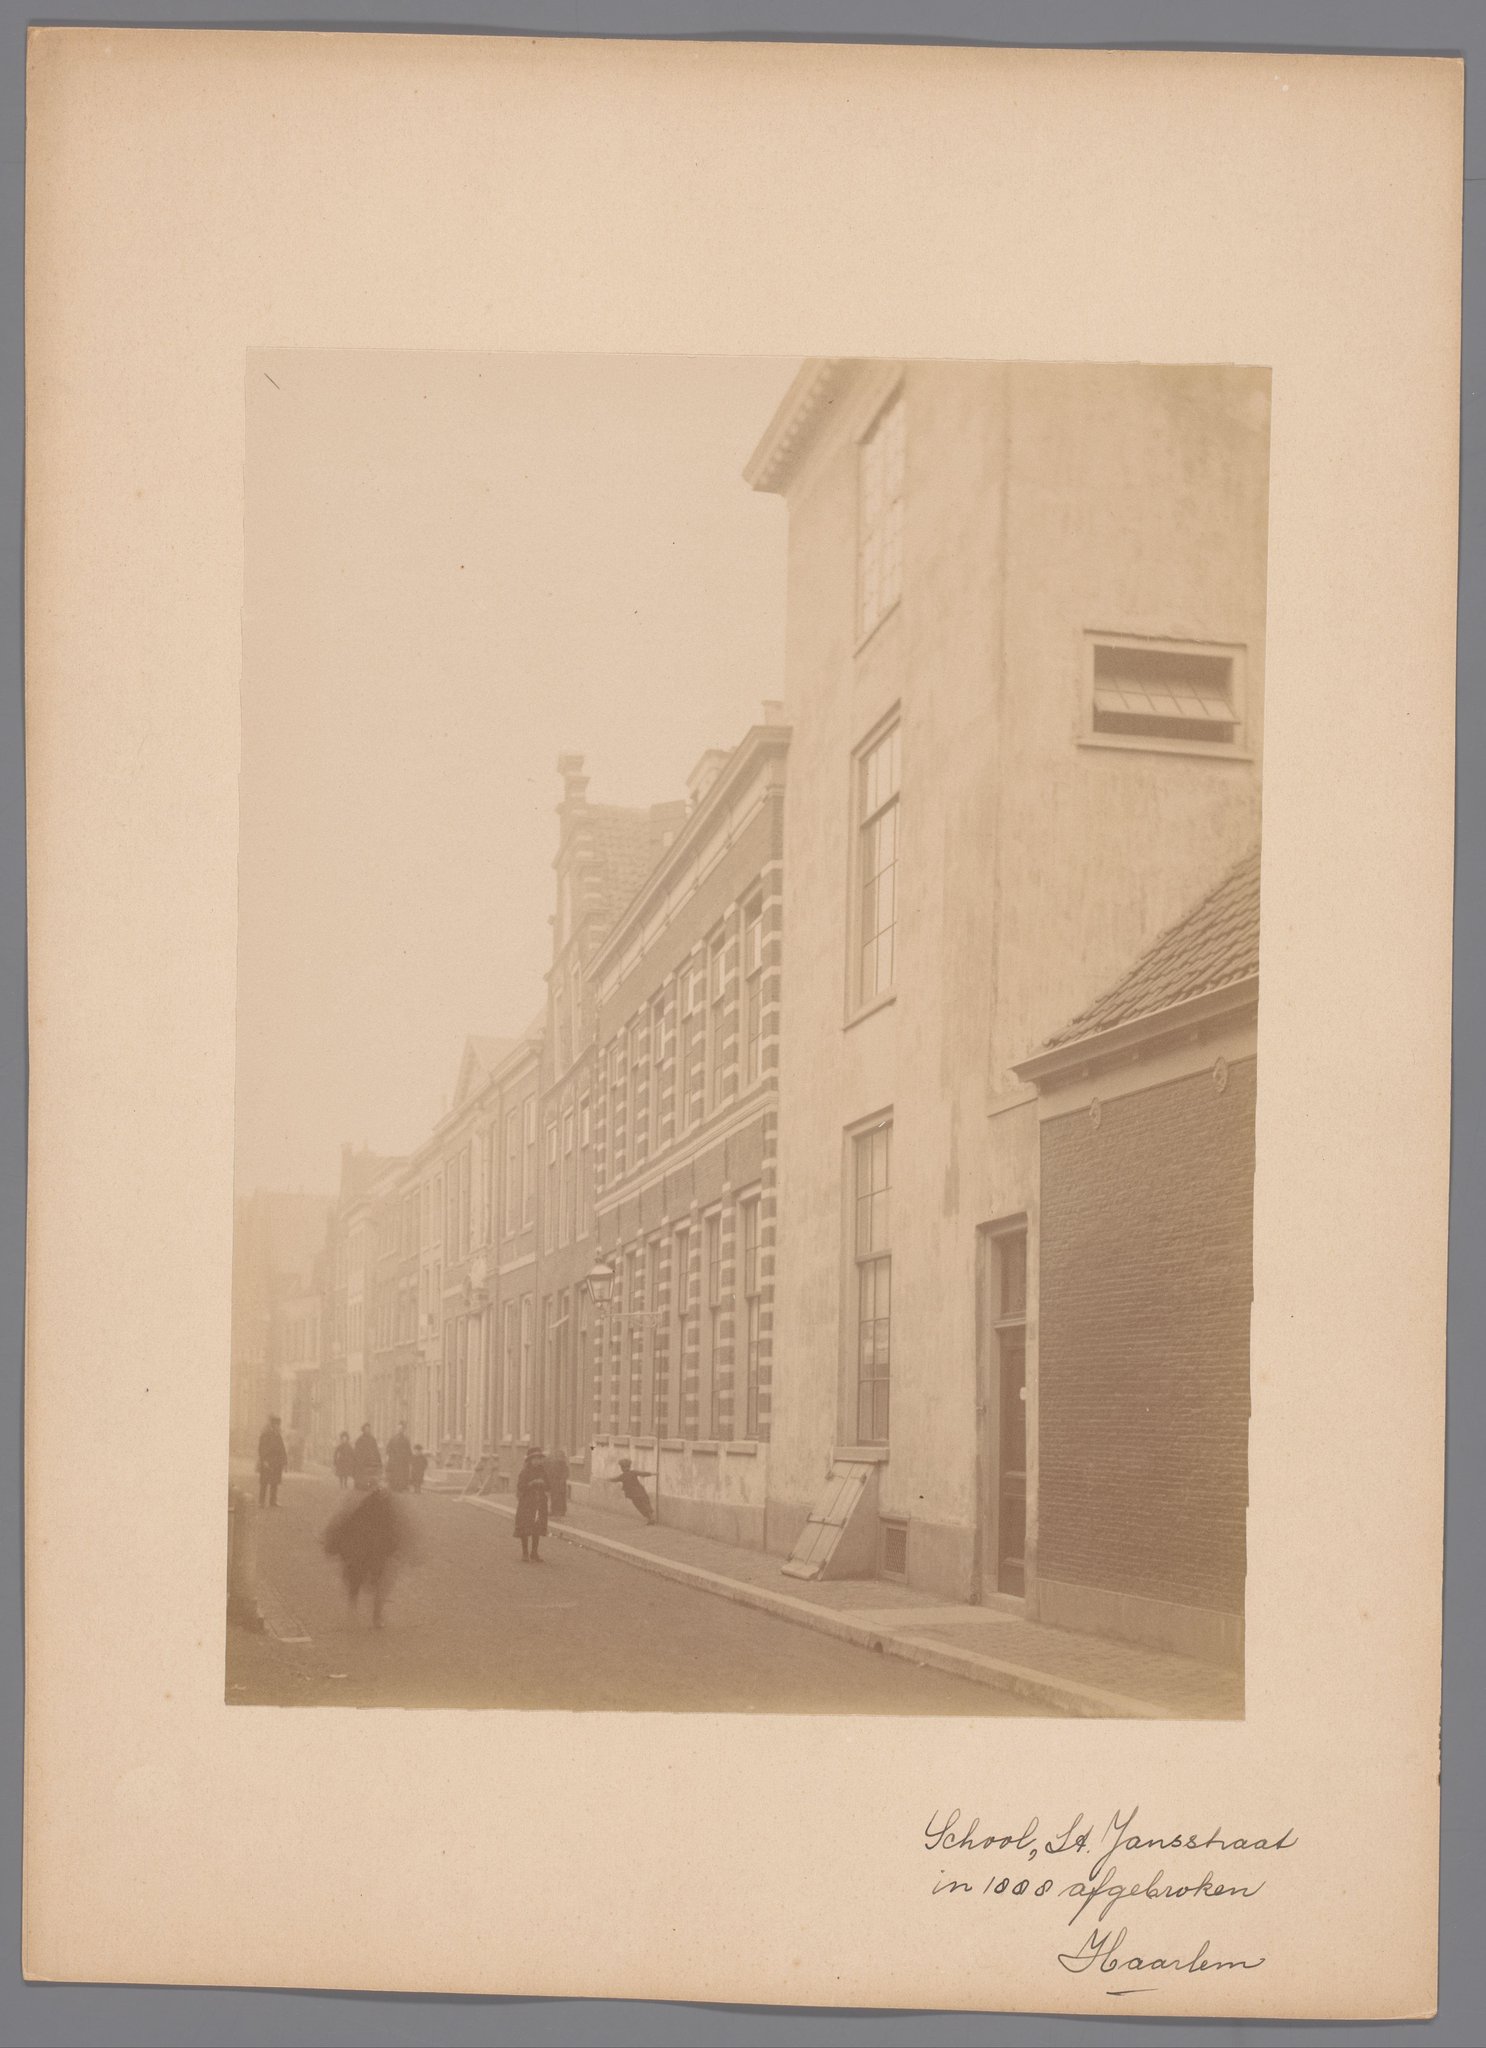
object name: photograph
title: Gezicht op een school in de Jansstraat te Haarlem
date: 1873-1888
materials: cardboard, photographic support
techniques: albumen print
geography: jansstraat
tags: elementary school; class, form (+ building ~ education, tuition), street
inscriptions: annotation: ‘Haarlem St. Jansstraat/ school in 1888 afgebroken’, annotation: ‘School, St. Jansstraat/ in 1888 afgebroken/ Haarlem’